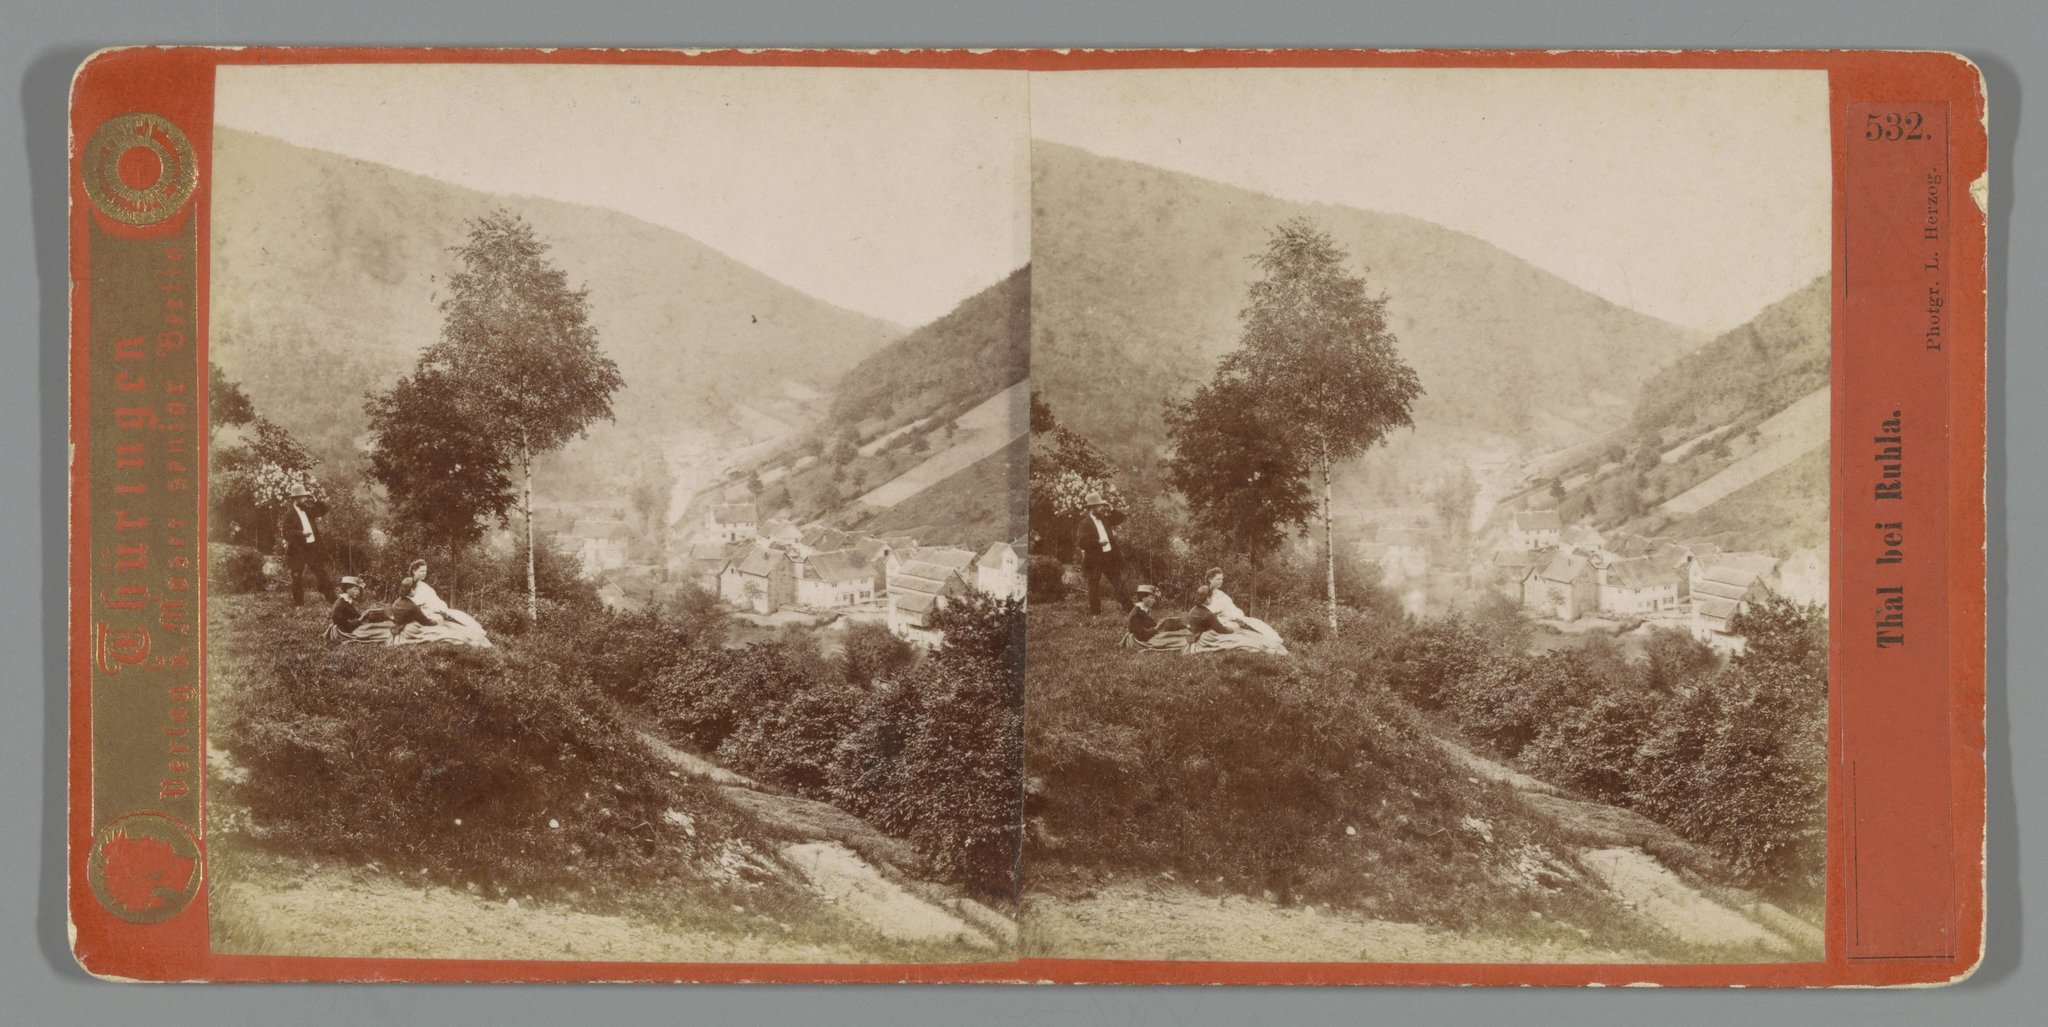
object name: stereograph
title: Gezicht op Ruhla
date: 1850-1880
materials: cardboard, photographic support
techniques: albumen print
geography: berlin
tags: ruhla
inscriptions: number: ‘532.’, inscription: ‘Photographischer und stereoscopischer (...) Glas-u. Papier-Stereoscopbildern aller Weltgegevenden’